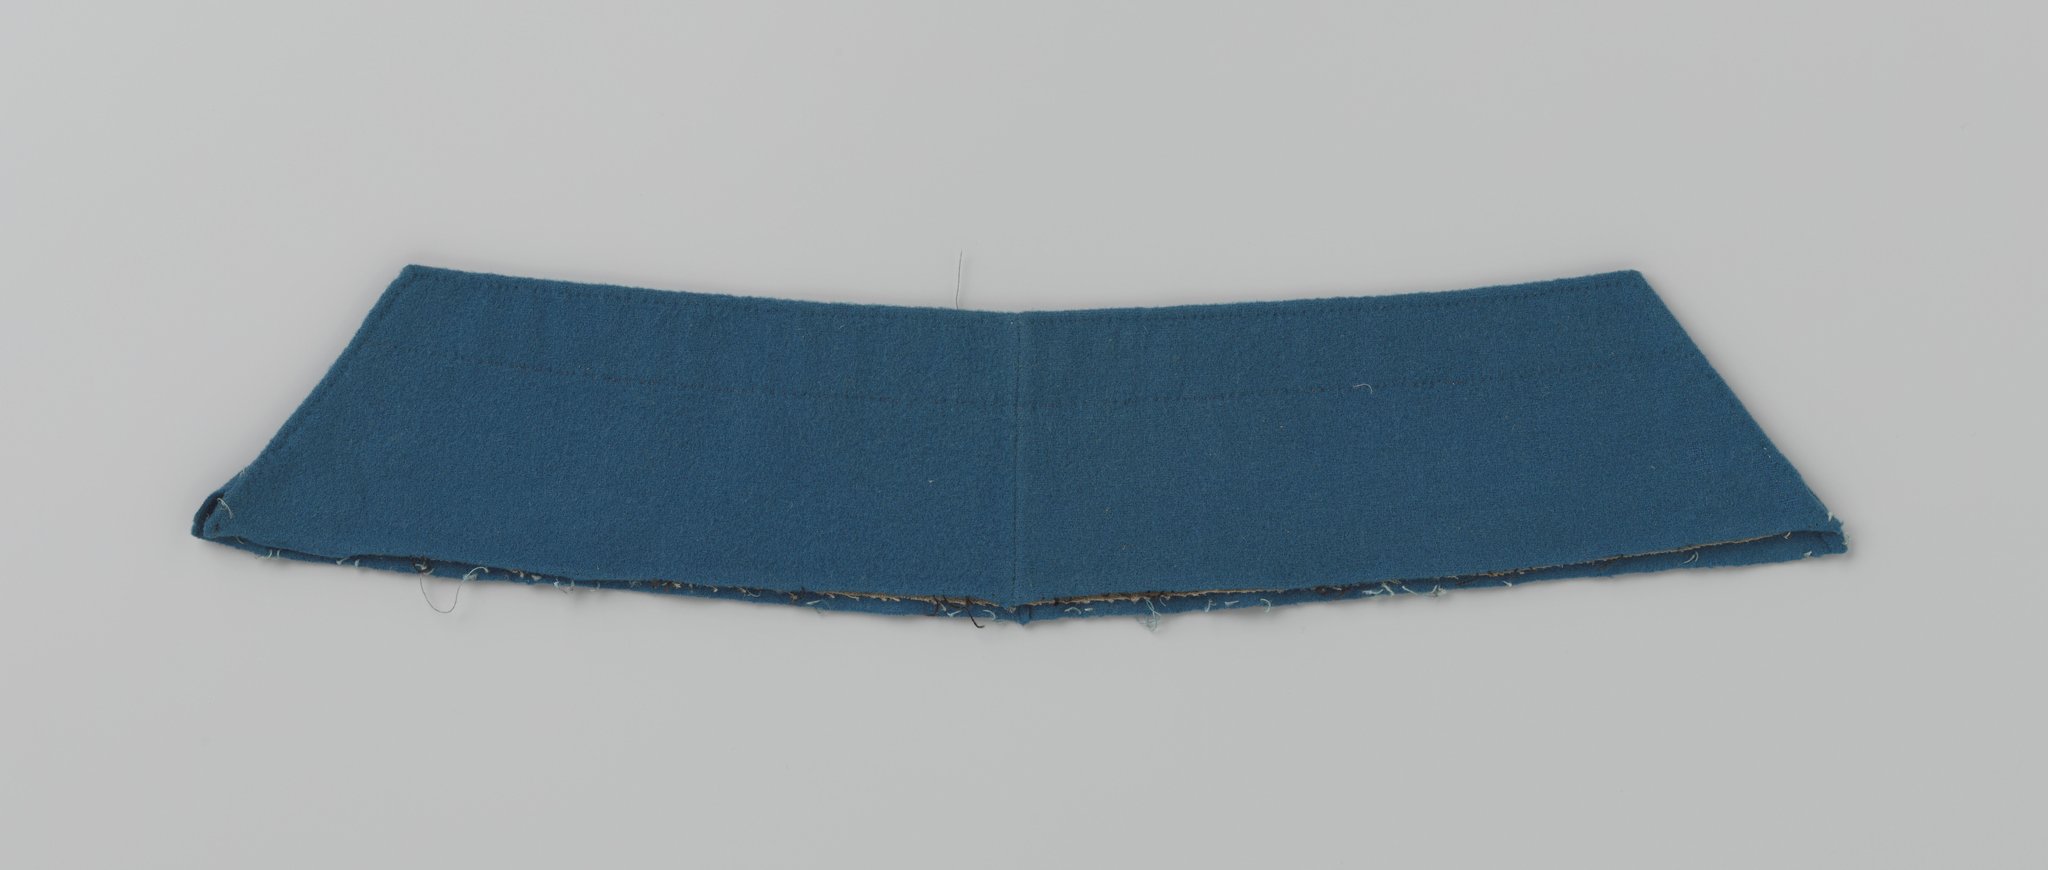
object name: collar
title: Kraag van blauw laken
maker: Anonymous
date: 1800-1825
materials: textile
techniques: sewing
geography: netherlands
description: Uniformfragmenten bestaande uit: twee kragen, manchetomslagen, paar revers met één en zeven paar lissen, voering en rug- en voorpanden; voor livrei of schutterij (?). Deze uniformfragmenten waren op het moment van invoer nog niet beschikbaar en daar de aantallen e.d. onduidelijk zijn, is bij deze invoer alleen volstaan met de vermelding van de diverse onderdelen. De invoer per onderdeel moet dus nog volgen.